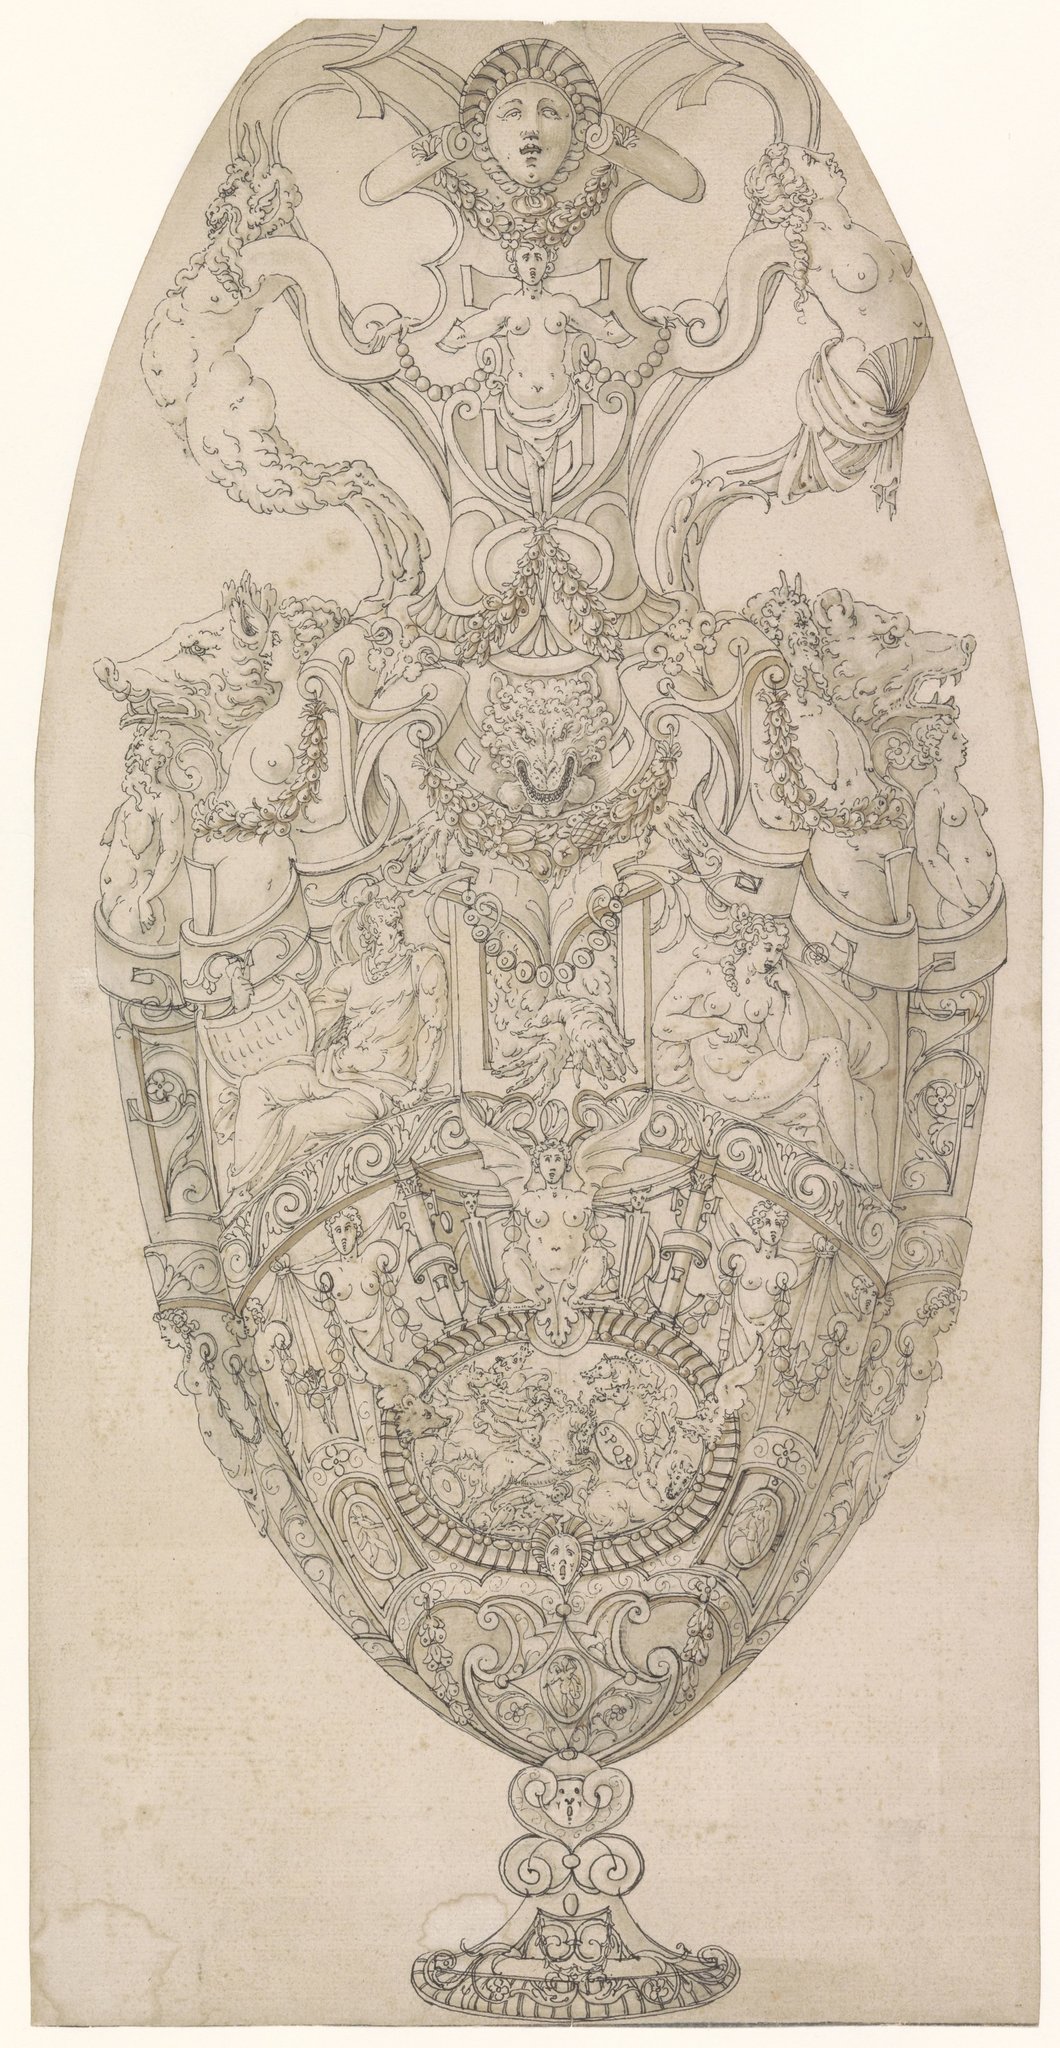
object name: ornamenttekening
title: Sierkan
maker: Anonymous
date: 1500-1600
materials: ink, paper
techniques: brush, pen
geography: france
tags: containers, vase ~ ornament